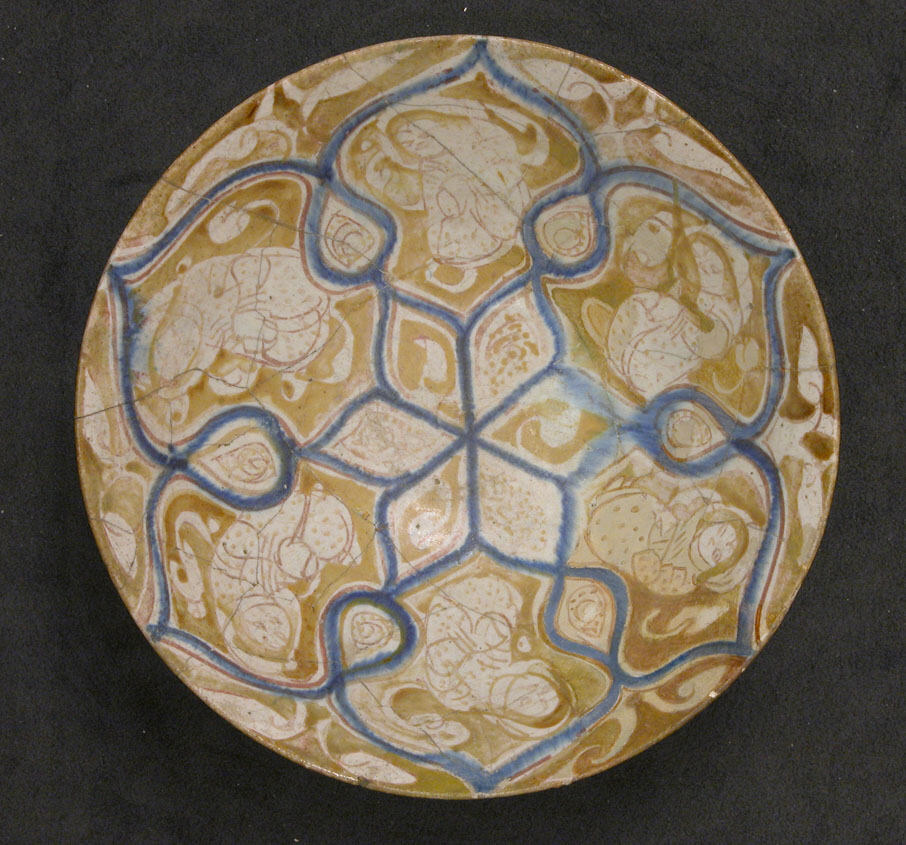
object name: bowl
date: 1101-1300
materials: stonepaste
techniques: luster painting, underglaze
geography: iran